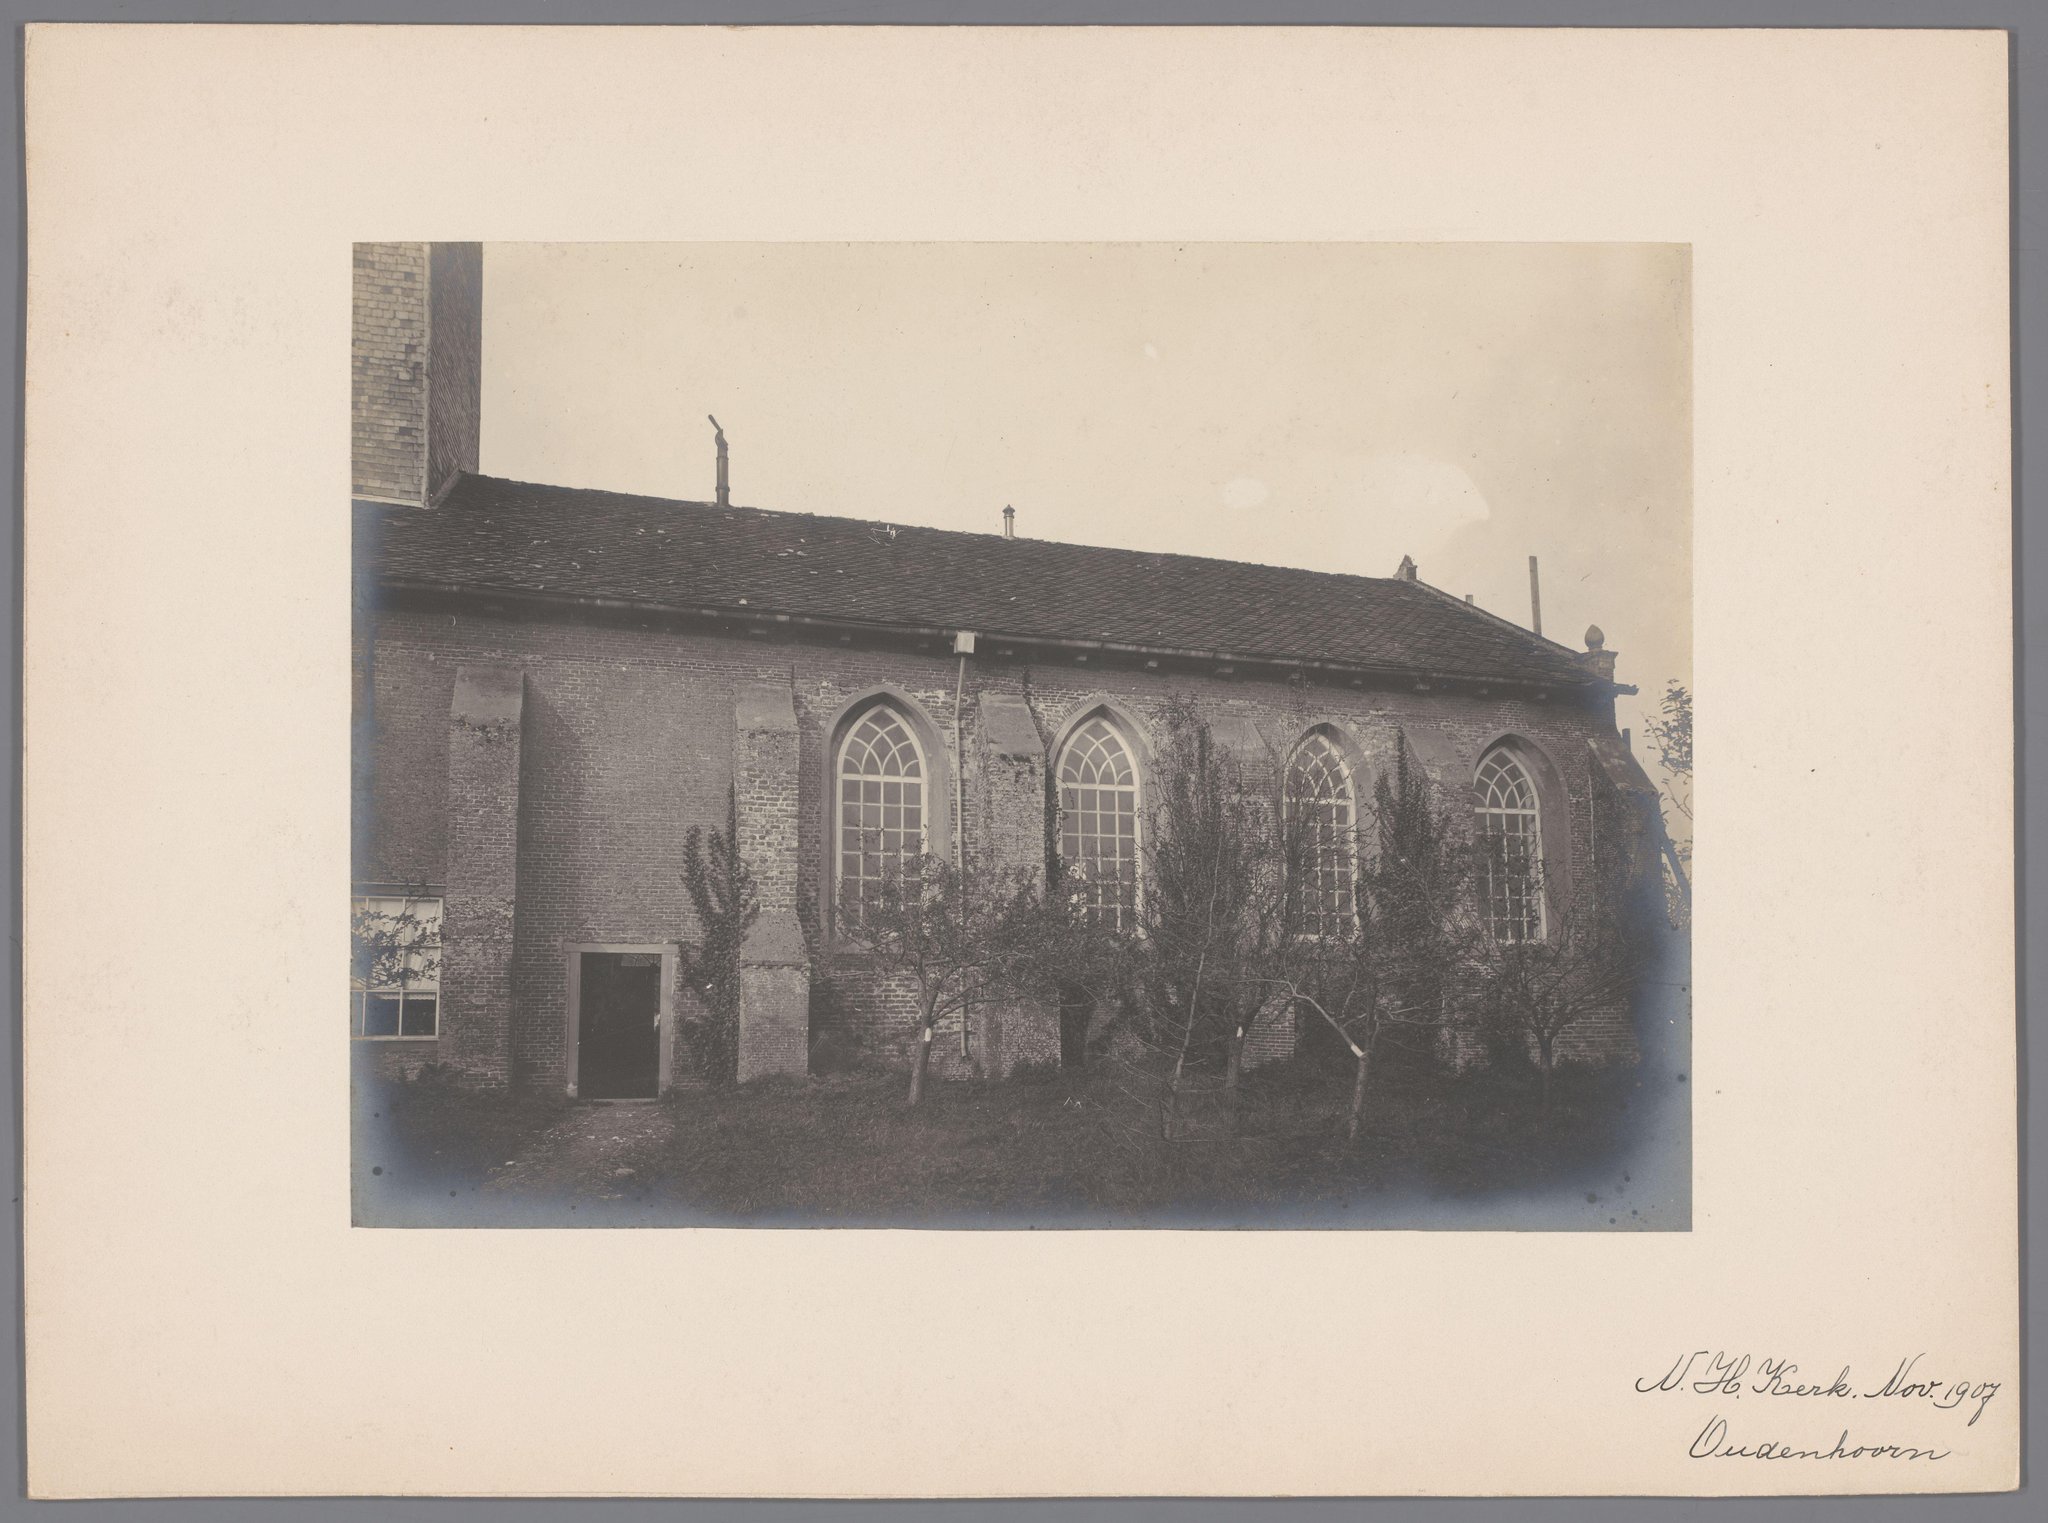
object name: photograph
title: Gezicht op de Hervormde Kerk te Oudenhoorn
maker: anoniem (monumentenzorg)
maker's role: fotograaf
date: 1907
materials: cardboard, photographic support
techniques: gelatin silver print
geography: oudenhoorn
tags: church (exterior)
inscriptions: annotation: ‘Oudenhoorn (Z.H.)/ Z Holland/ N.H. Kerk nov 1907’, annotation: ‘N.H. Kerk Nov. 1907/ Oudenhoorn’